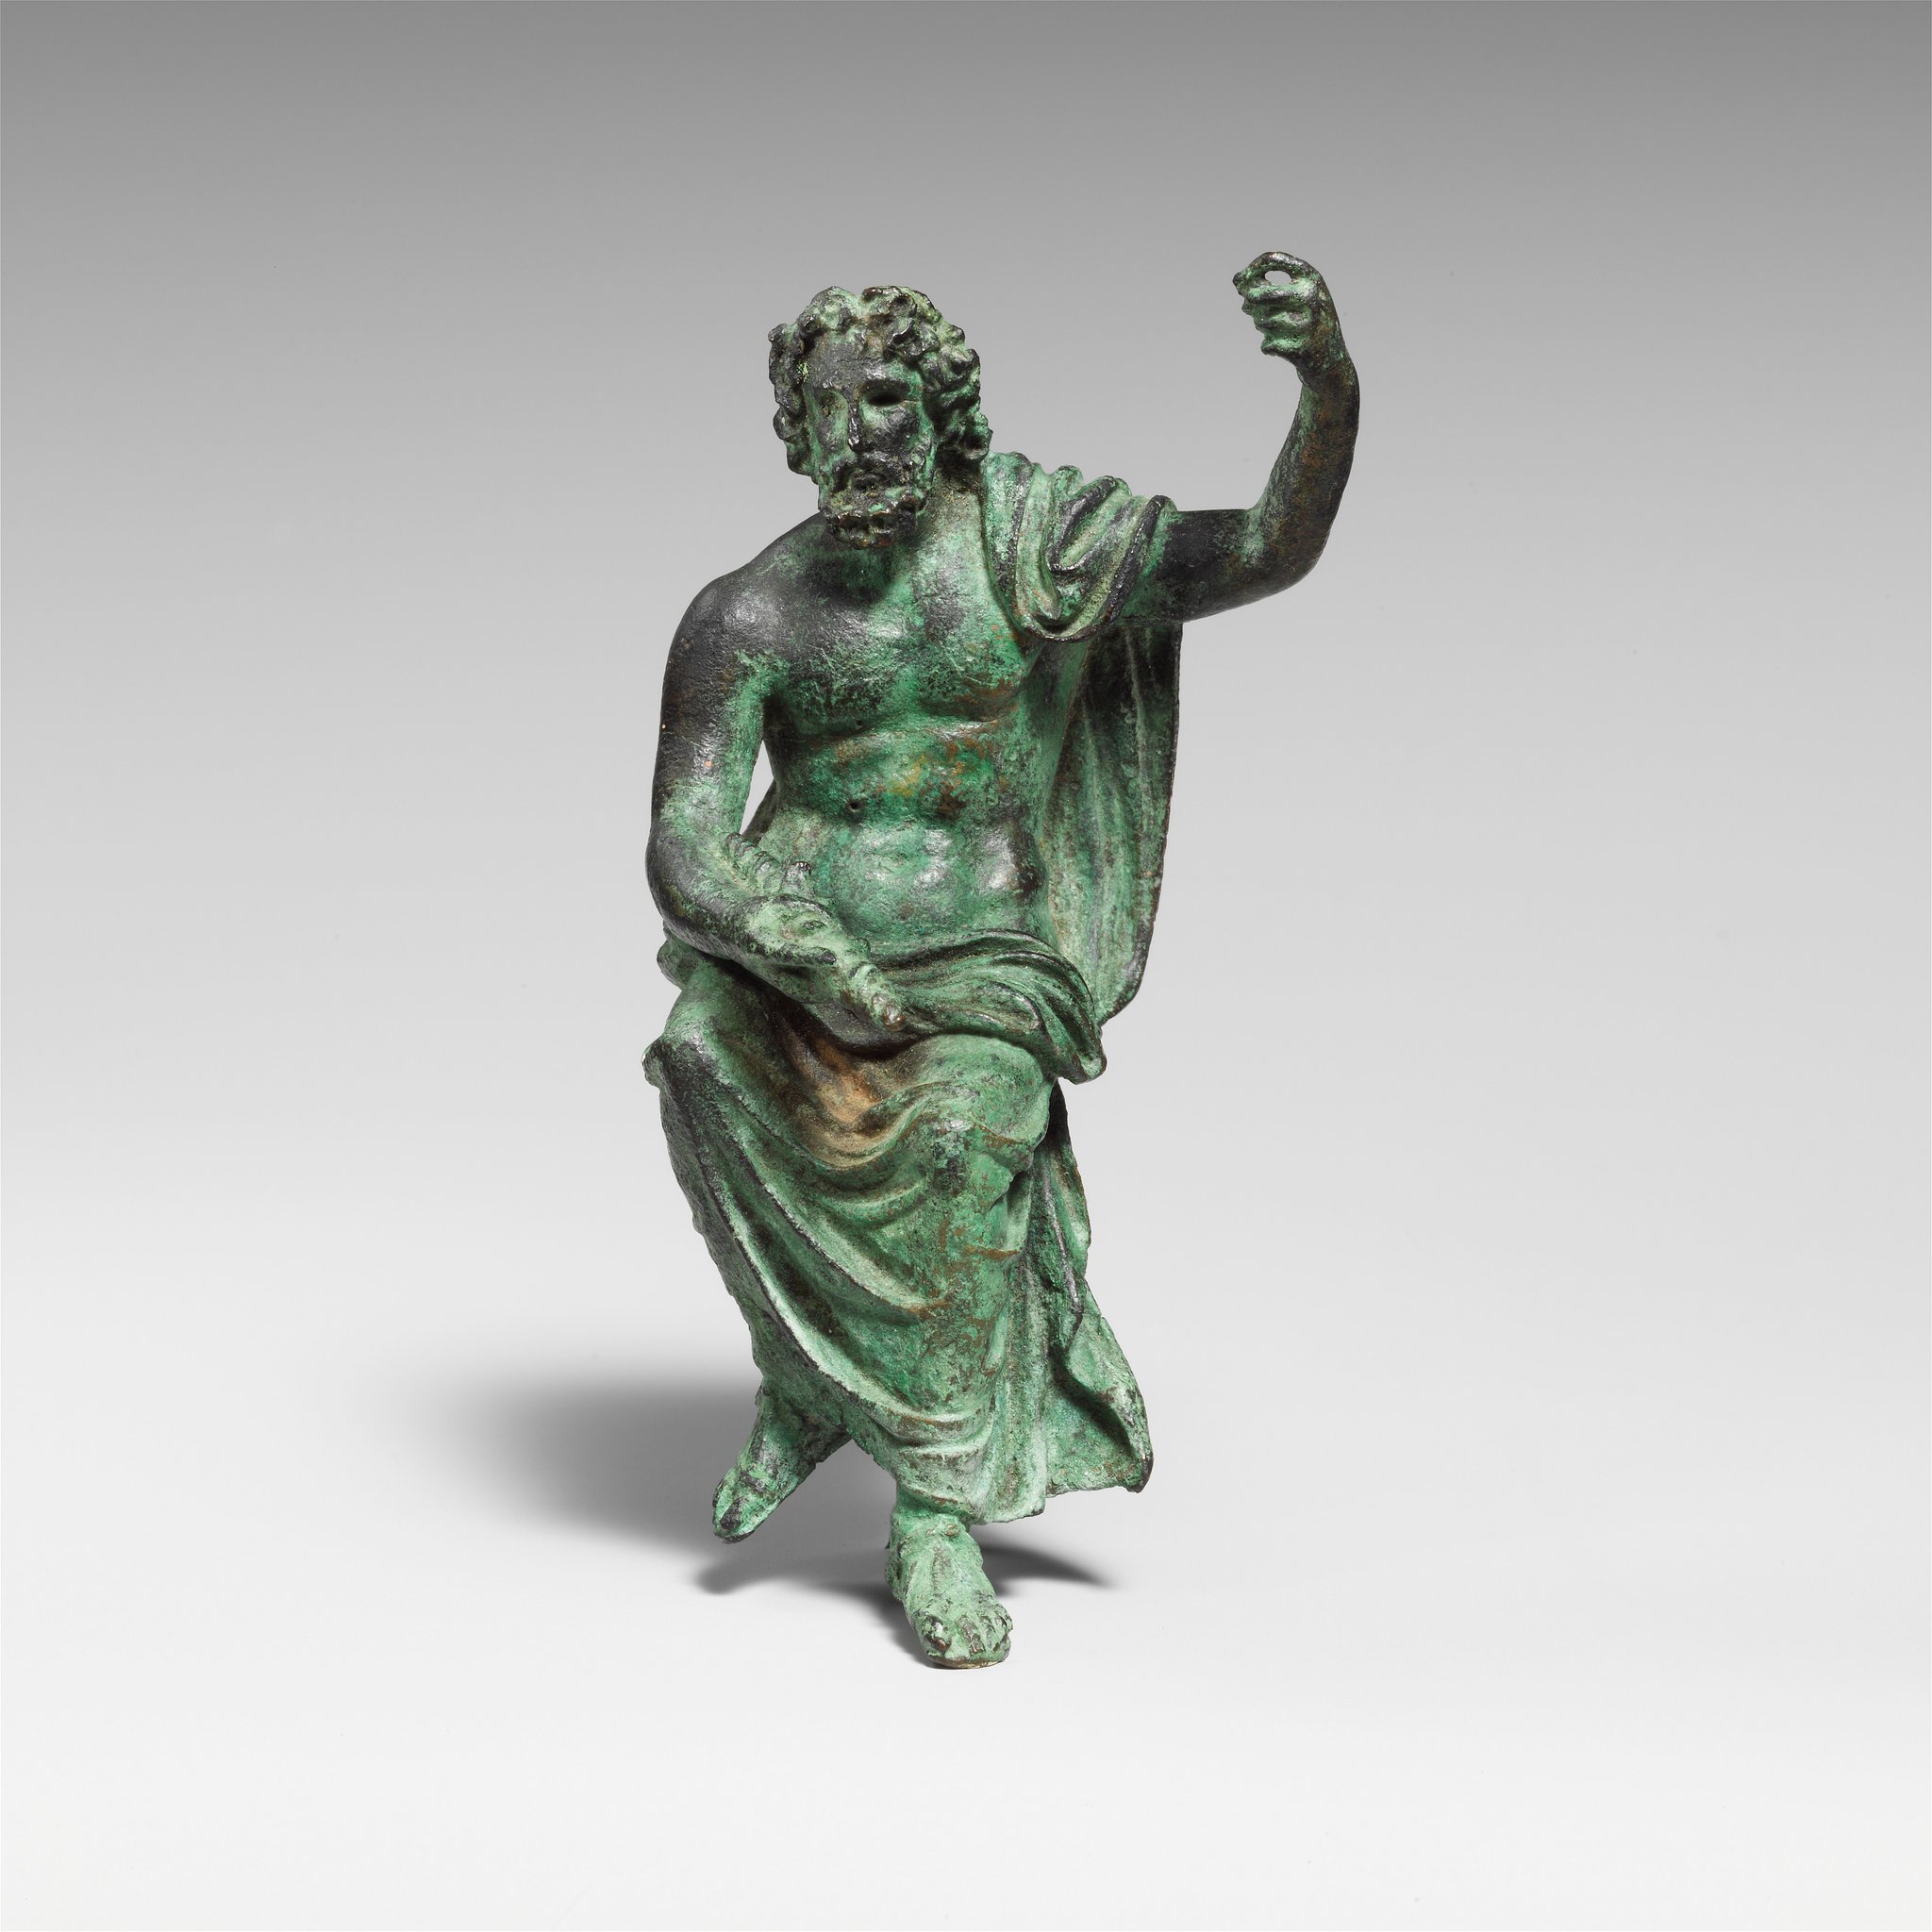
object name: statuette of jupiter capitolinus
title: Bronze statuette of Jupiter Capitolinus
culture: roman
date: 1-200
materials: bronze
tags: jupiter